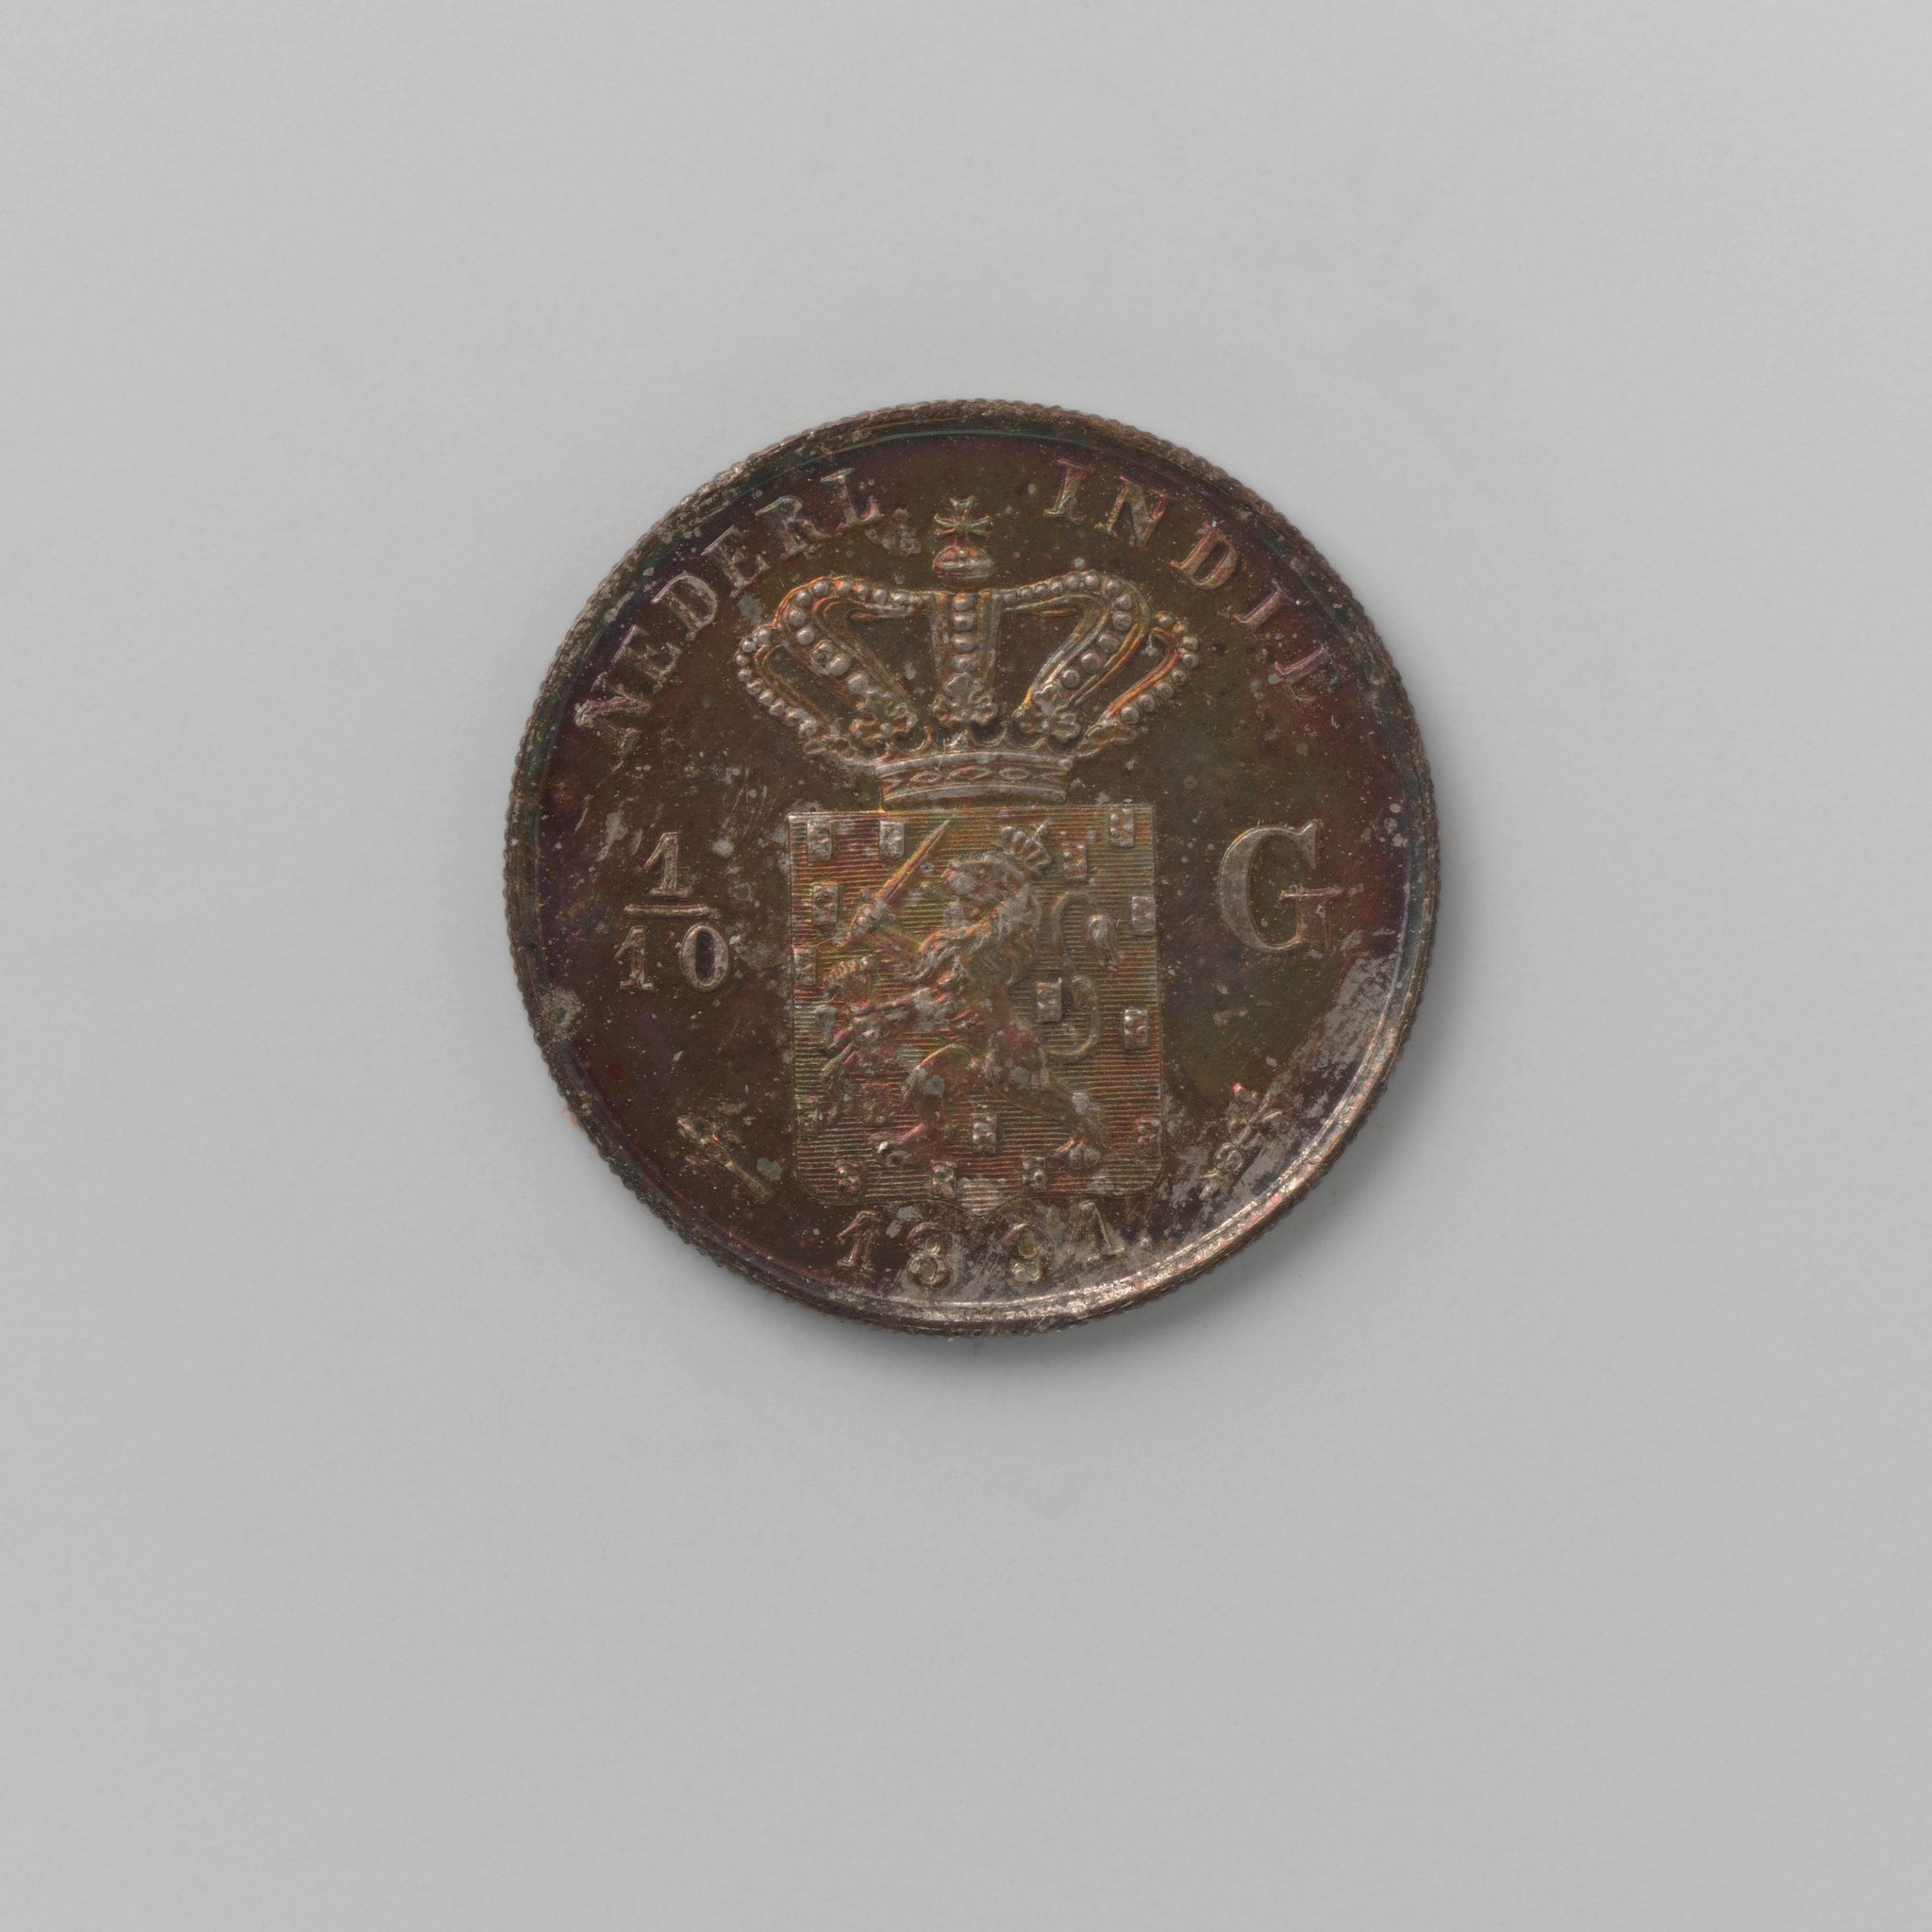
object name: coin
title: 1/10 gulden van Nederlands Indië,1891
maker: wilhelmina of the netherlands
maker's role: print maker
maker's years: 1880-1962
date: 1891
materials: copper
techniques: striking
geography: utrecht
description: Zilveren munt. Voorzijde: tussen waarde-aanduiding 1/10 G gekroond rijkswapenschild. Boven kroon landsaanduiding en onder wapenschild jaartal. Keerzijde: tweeregelig Maleis opschrift in Arabische tekens, waaromheen omschrift in het Javaans. Kartelrand.